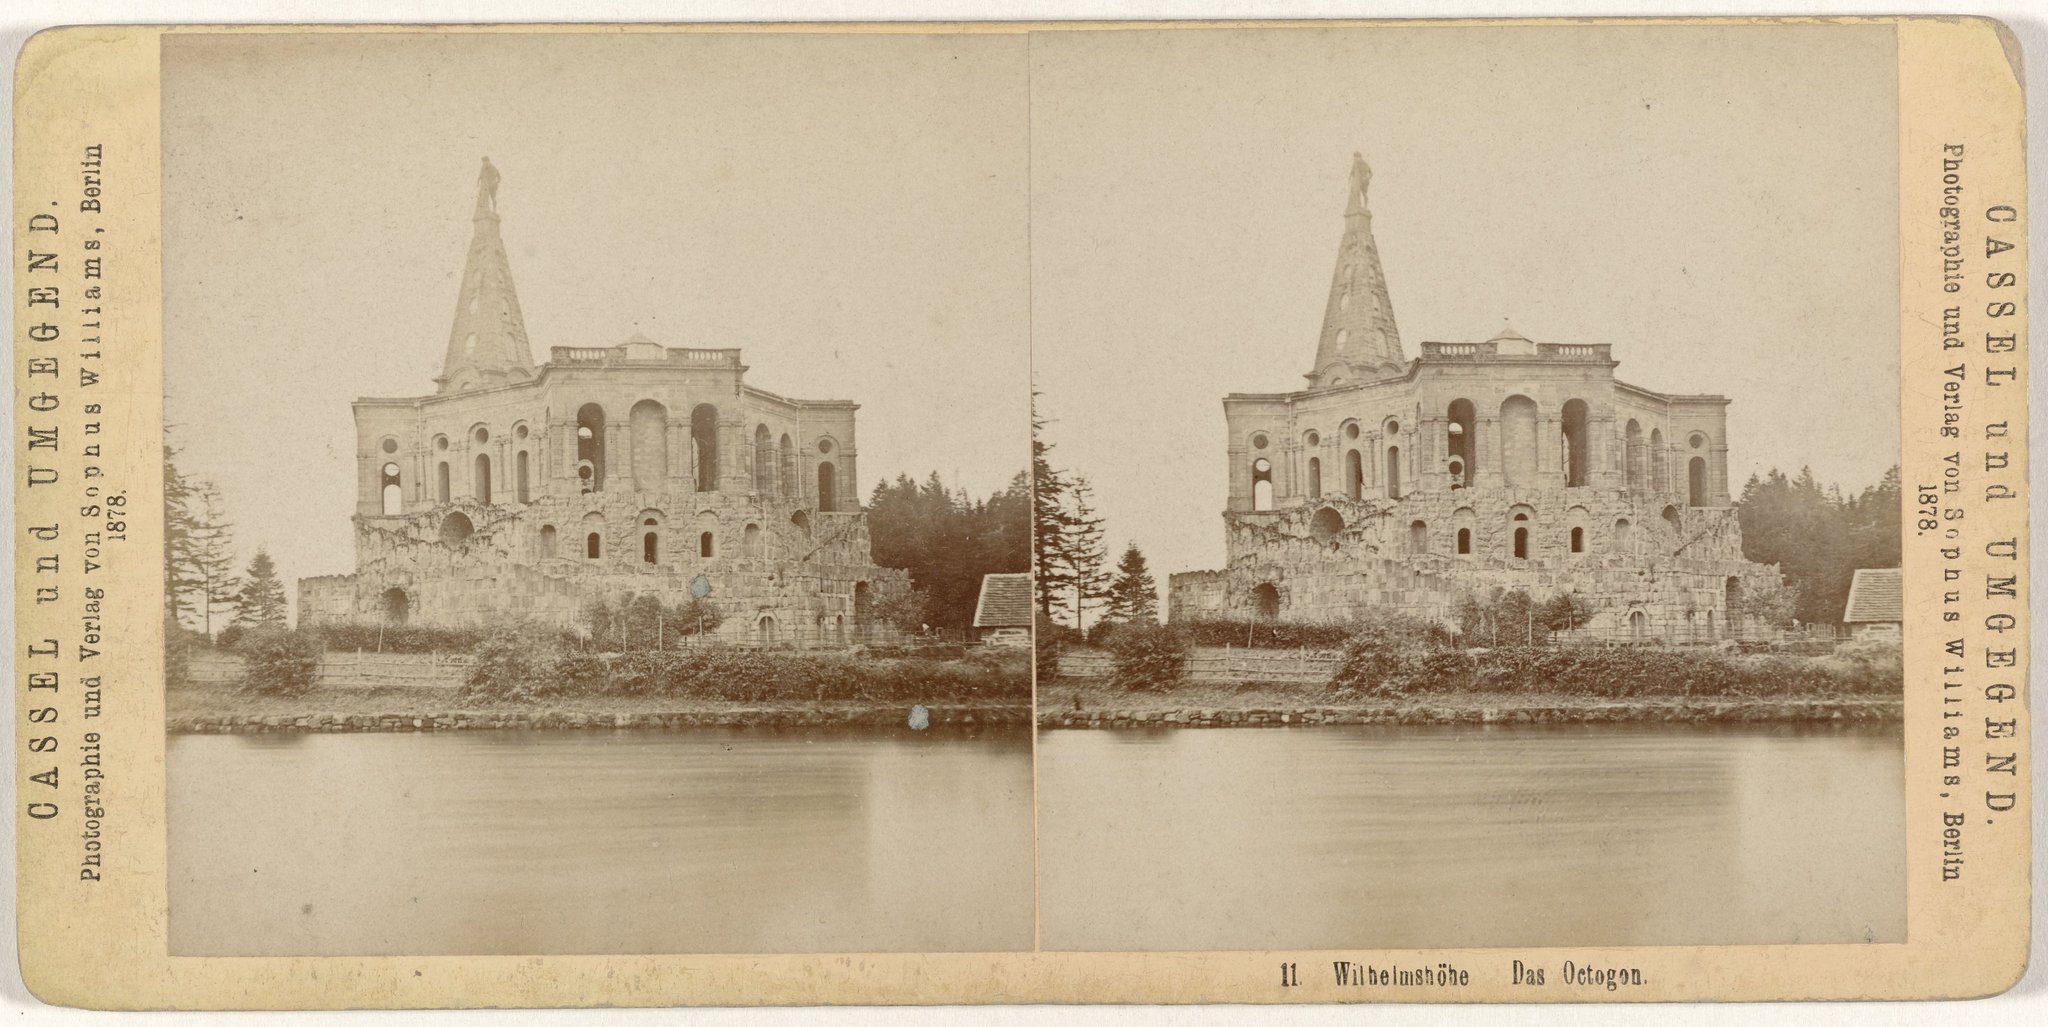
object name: stereograph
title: Cassel und Umgegend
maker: sophus williams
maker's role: publisher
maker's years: 1835-1900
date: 1878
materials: cardboard, paper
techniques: albumen print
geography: kassel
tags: landscape with monument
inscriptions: number: ‘11.’